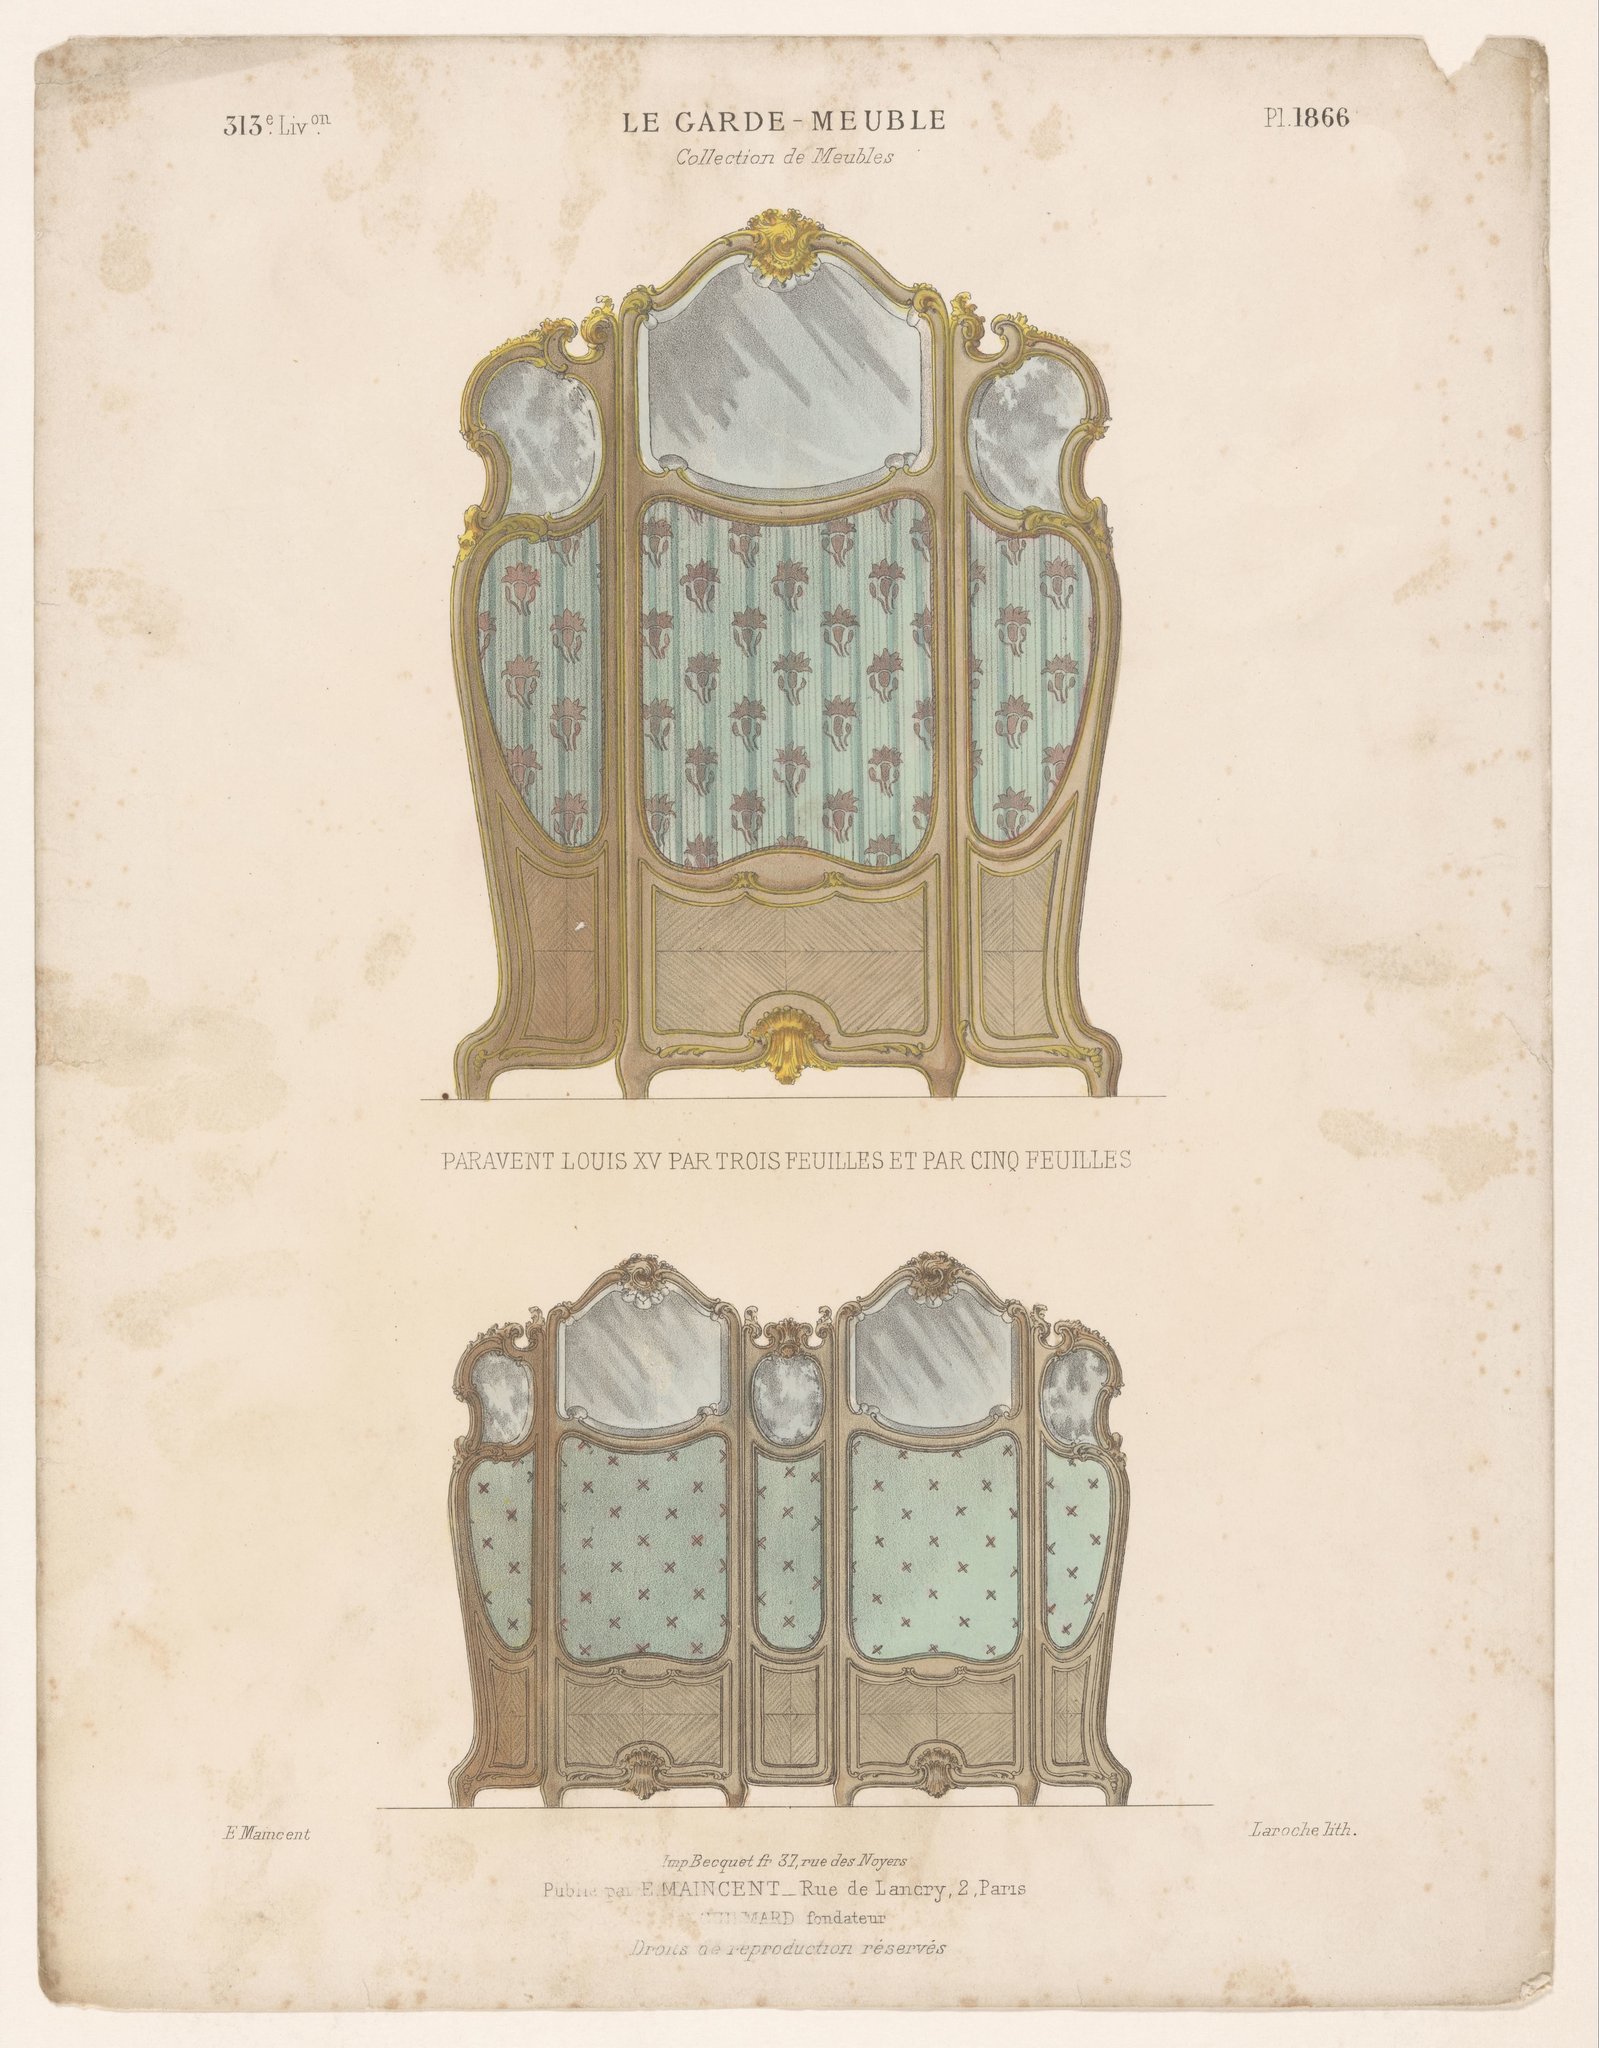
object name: print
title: Paravent Louis XV par trois feuilles et par cinq feuilles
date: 1885-1895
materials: paper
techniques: hand coloring, lithograph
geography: paris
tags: screen, folding screen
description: Ieder Livraison in de serie Le Garde-Meuble bevat negen platen: drie 'sièges' (zitmeubels), drie 'meubles' (diverse meubels zoals tafels en kasten) en drie 'tentures' (gordijnen en draperieën).